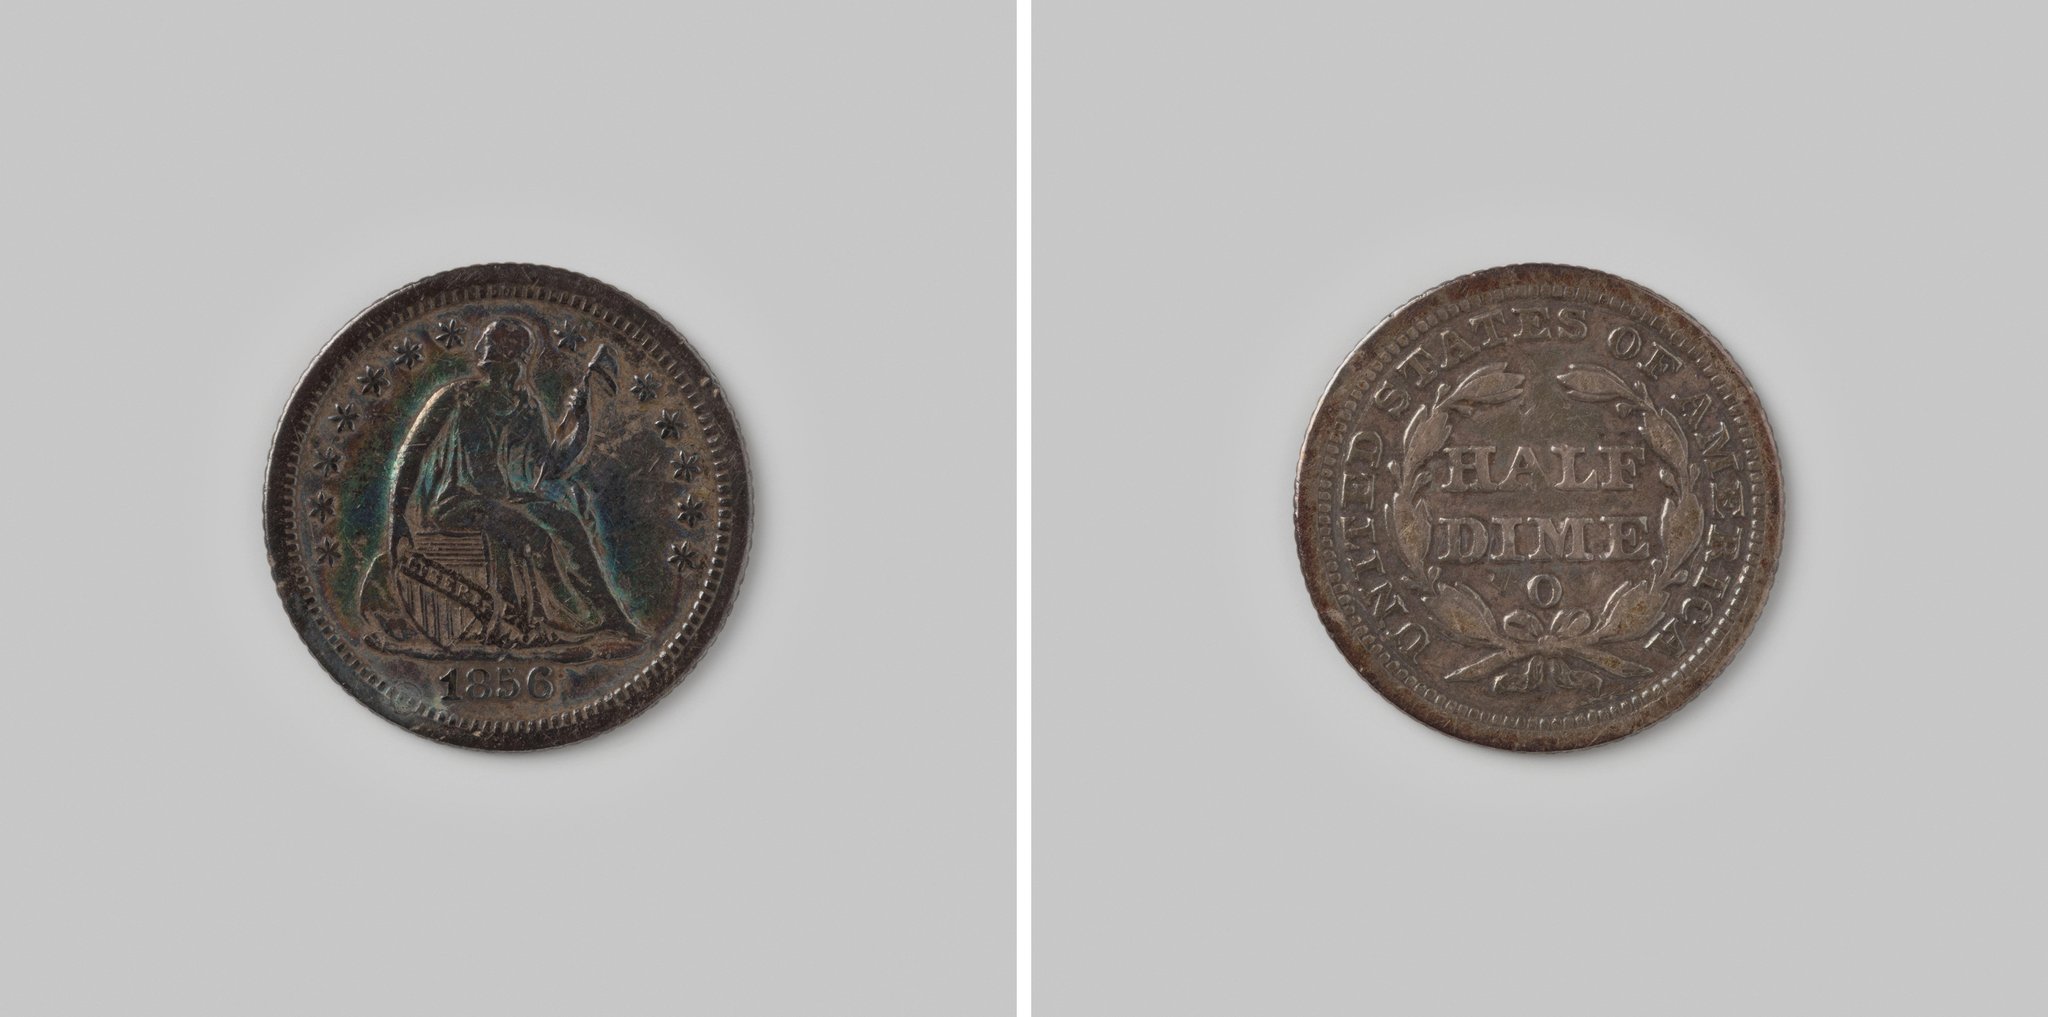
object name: coin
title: Verenigde Staten van Amerika, ½ dime of 5 cents, 1856 O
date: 1856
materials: silver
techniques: striking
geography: new orleans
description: Zilveren munt. Voorzijde: liberty seated, naar links omkijkend, met in de linkerhand speer met vaan en in rechterhand wapenschild. Daaromheen sterren. Onderaan jaartal. Keerzijde: binnen twee samengebonden takken in twee regels waarde-aanduiding: half dime. Daaronder letter O. Kartelrand.